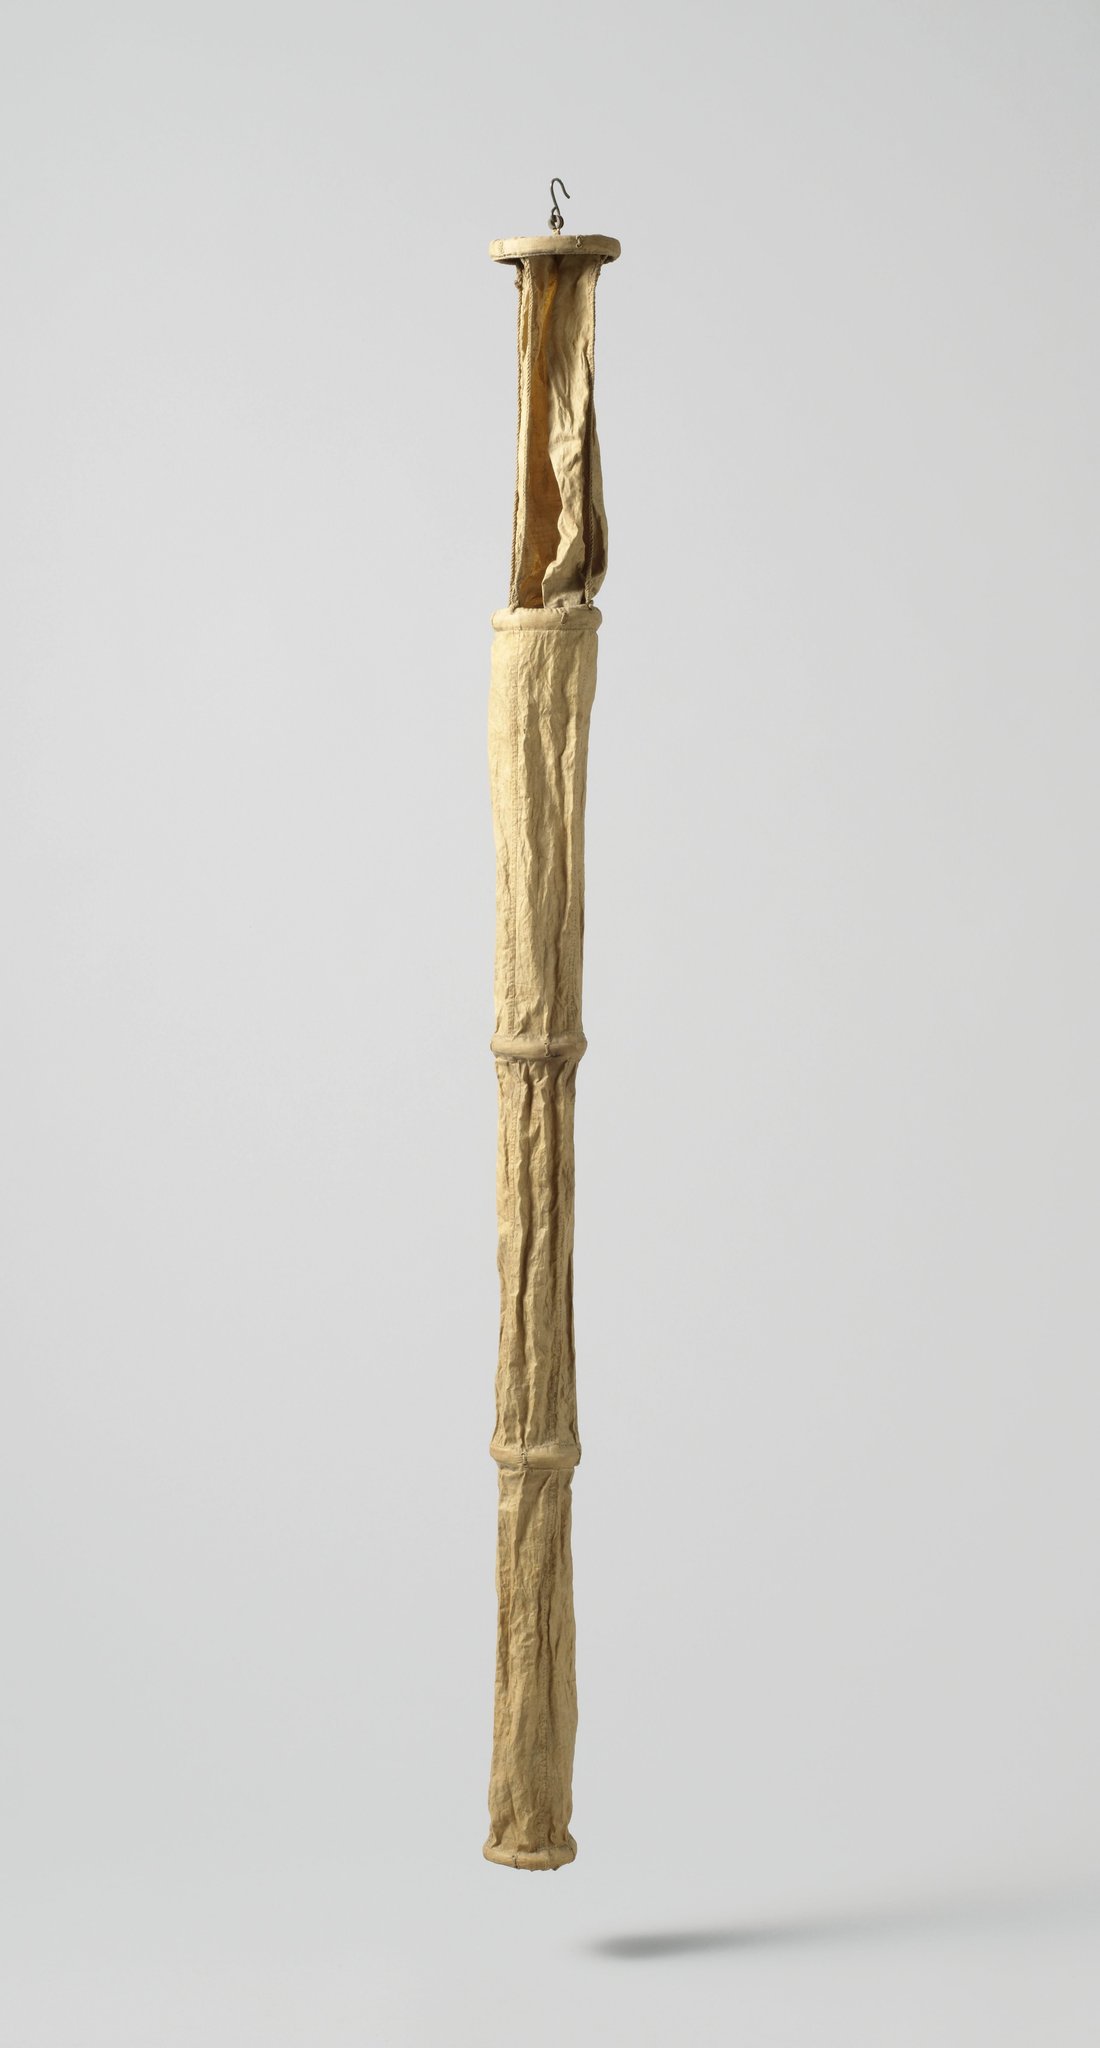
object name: demonstration model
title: Model of a Windsail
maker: Anonymous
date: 1850-1870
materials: brass, copper, fiber, textile, wood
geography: netherlands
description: Model van een koelzeil. De vijf hoepels zijn van hout met touw omwonden. Het bovenste stuk tussen de eerste twee hoepels bestaat uit een vier stukken doek in een kruis aan elkaar genaaid; zo ontstaan vier openingen, één voor iedere windrichting. Het onderste deel is een doeken ventilatieschacht verstevigd met hoepels. Schaal 1:10 (volgens Obreen).